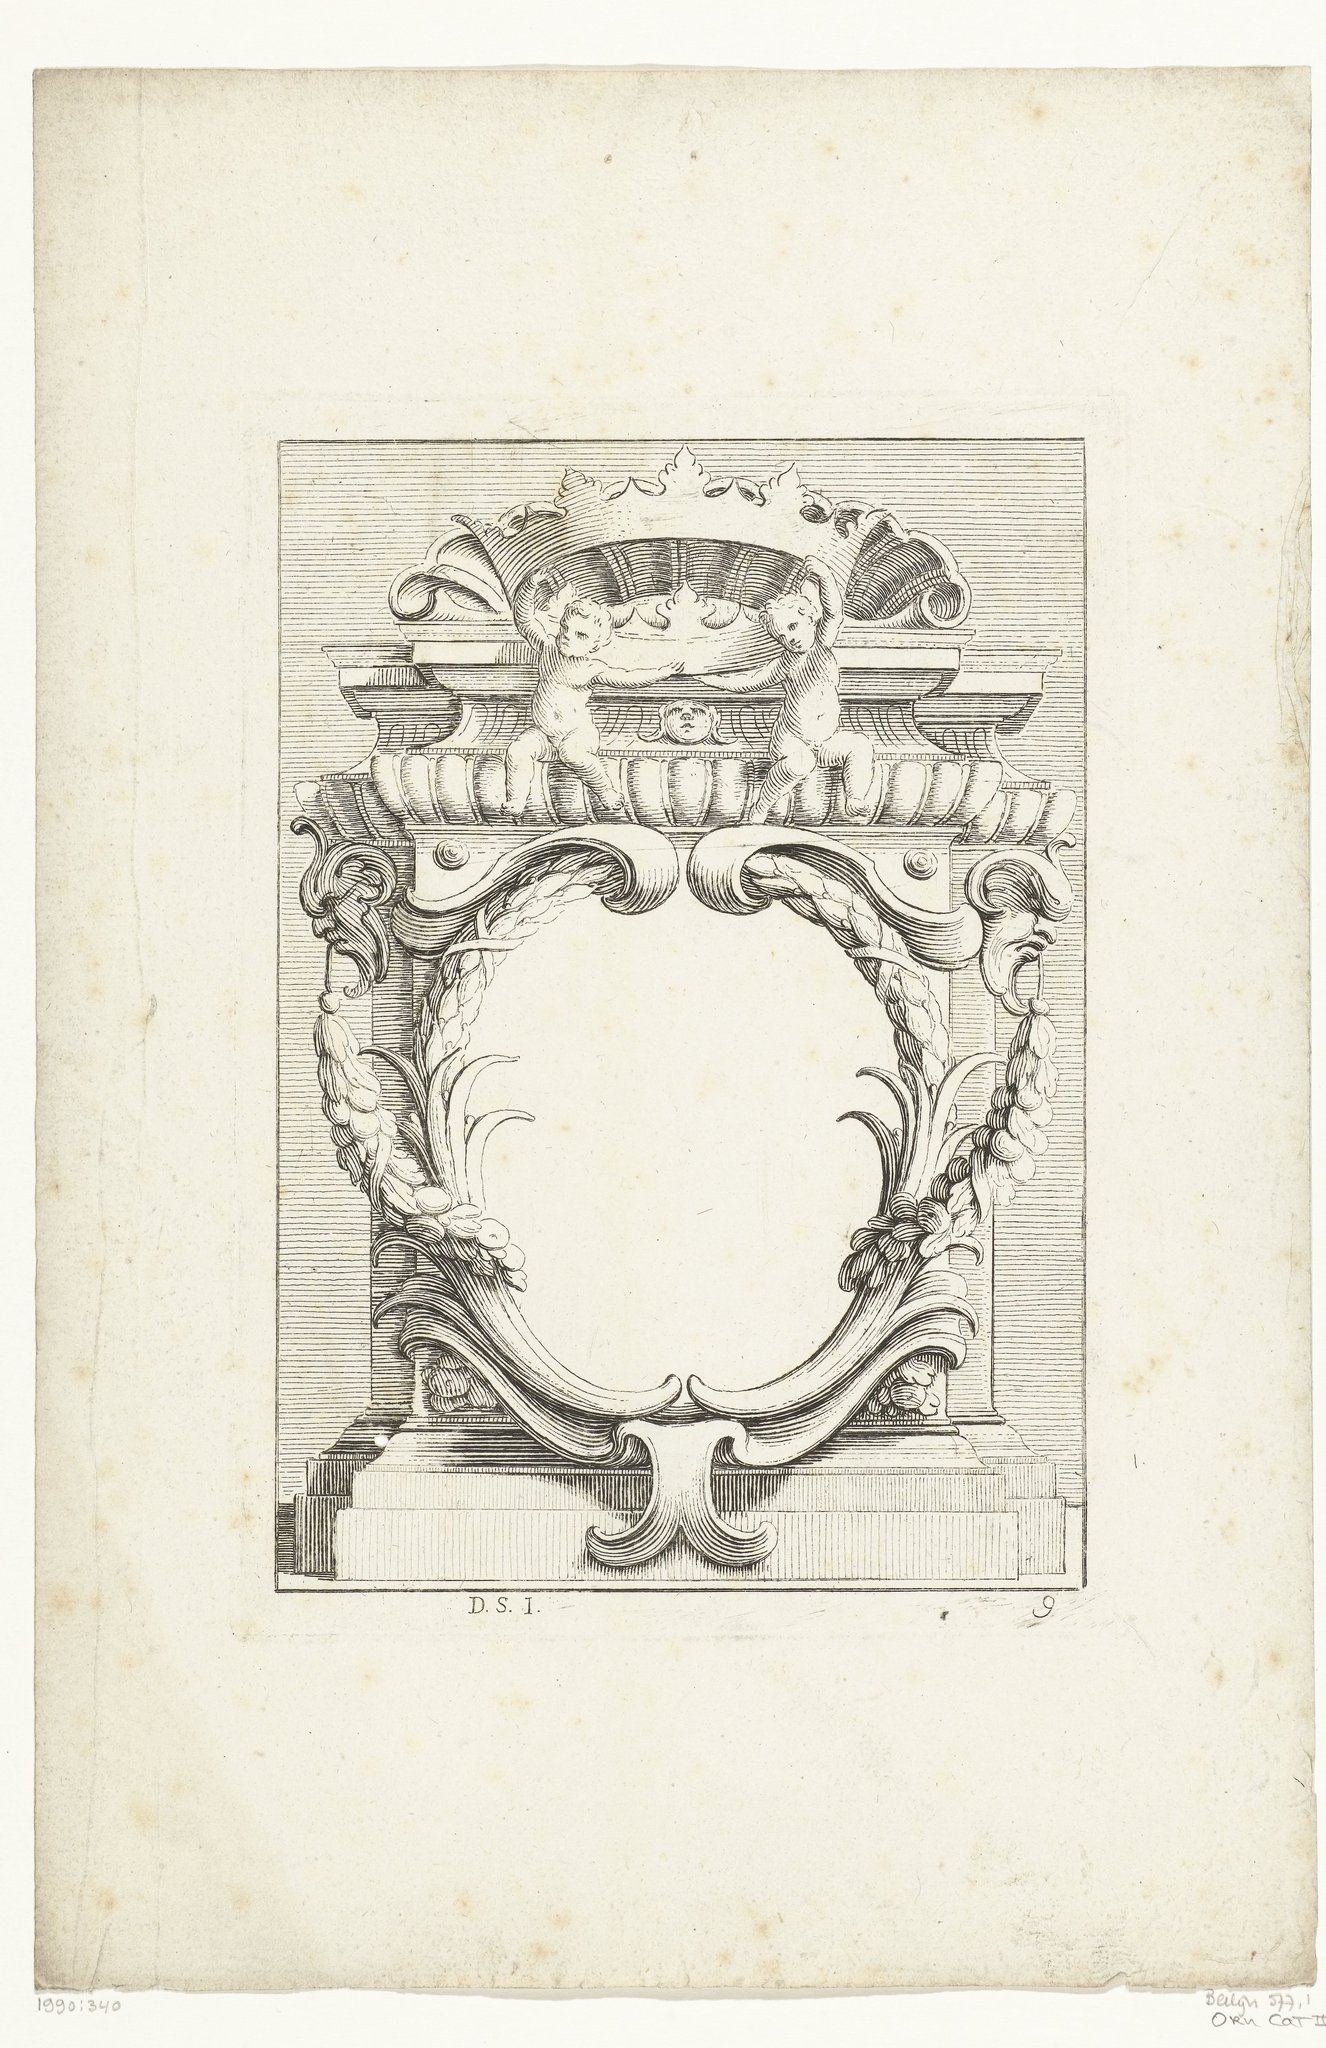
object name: print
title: Cartouche tegen voetstuk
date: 1670-1680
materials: paper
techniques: etching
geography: bologna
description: Boven de cartouche bevinden zich twee kinderen die een open kroon vasthouden.